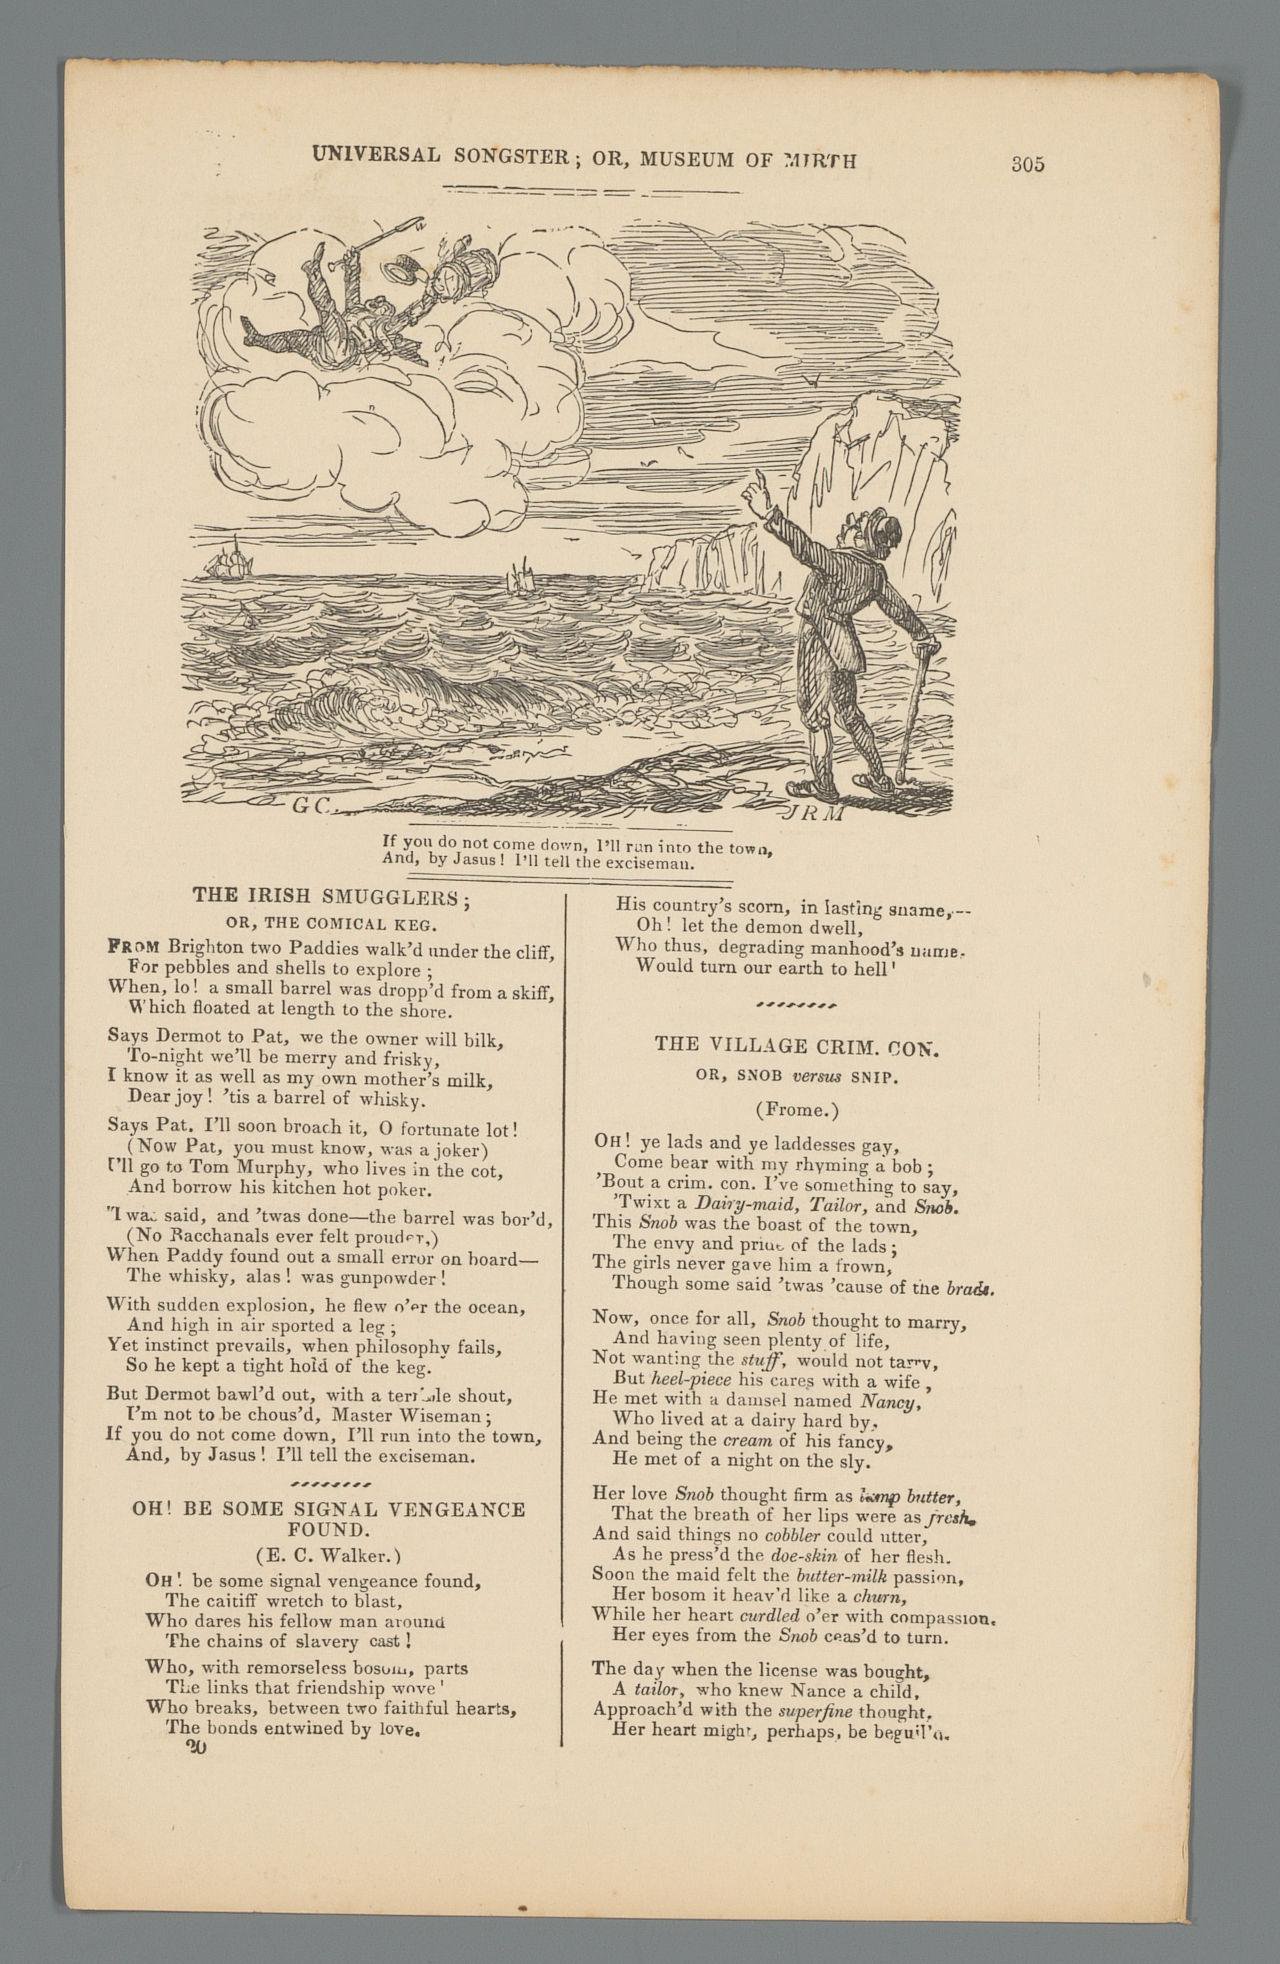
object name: book illustration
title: The Irish smugglers; or, the comical keg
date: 1825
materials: paper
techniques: engraving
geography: england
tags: projectiles, explosives, etc.: gunpowder, rocky coast, smuggler, political caricatures and satires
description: Een Ierse smokkelaar staande aan de kust roept naar een andere Ier die in de lucht zweeft met een vat buskruit. Spotprent bij een blad met de tekst van het lied: The Irish smugglers; or, the comical keg. Illustratie (p. 305/306) genomen uit een uitgave van de liederenbundel: The Universal Songster, or Museum of Mirth, vol. I., eerst verschenen in 1825.